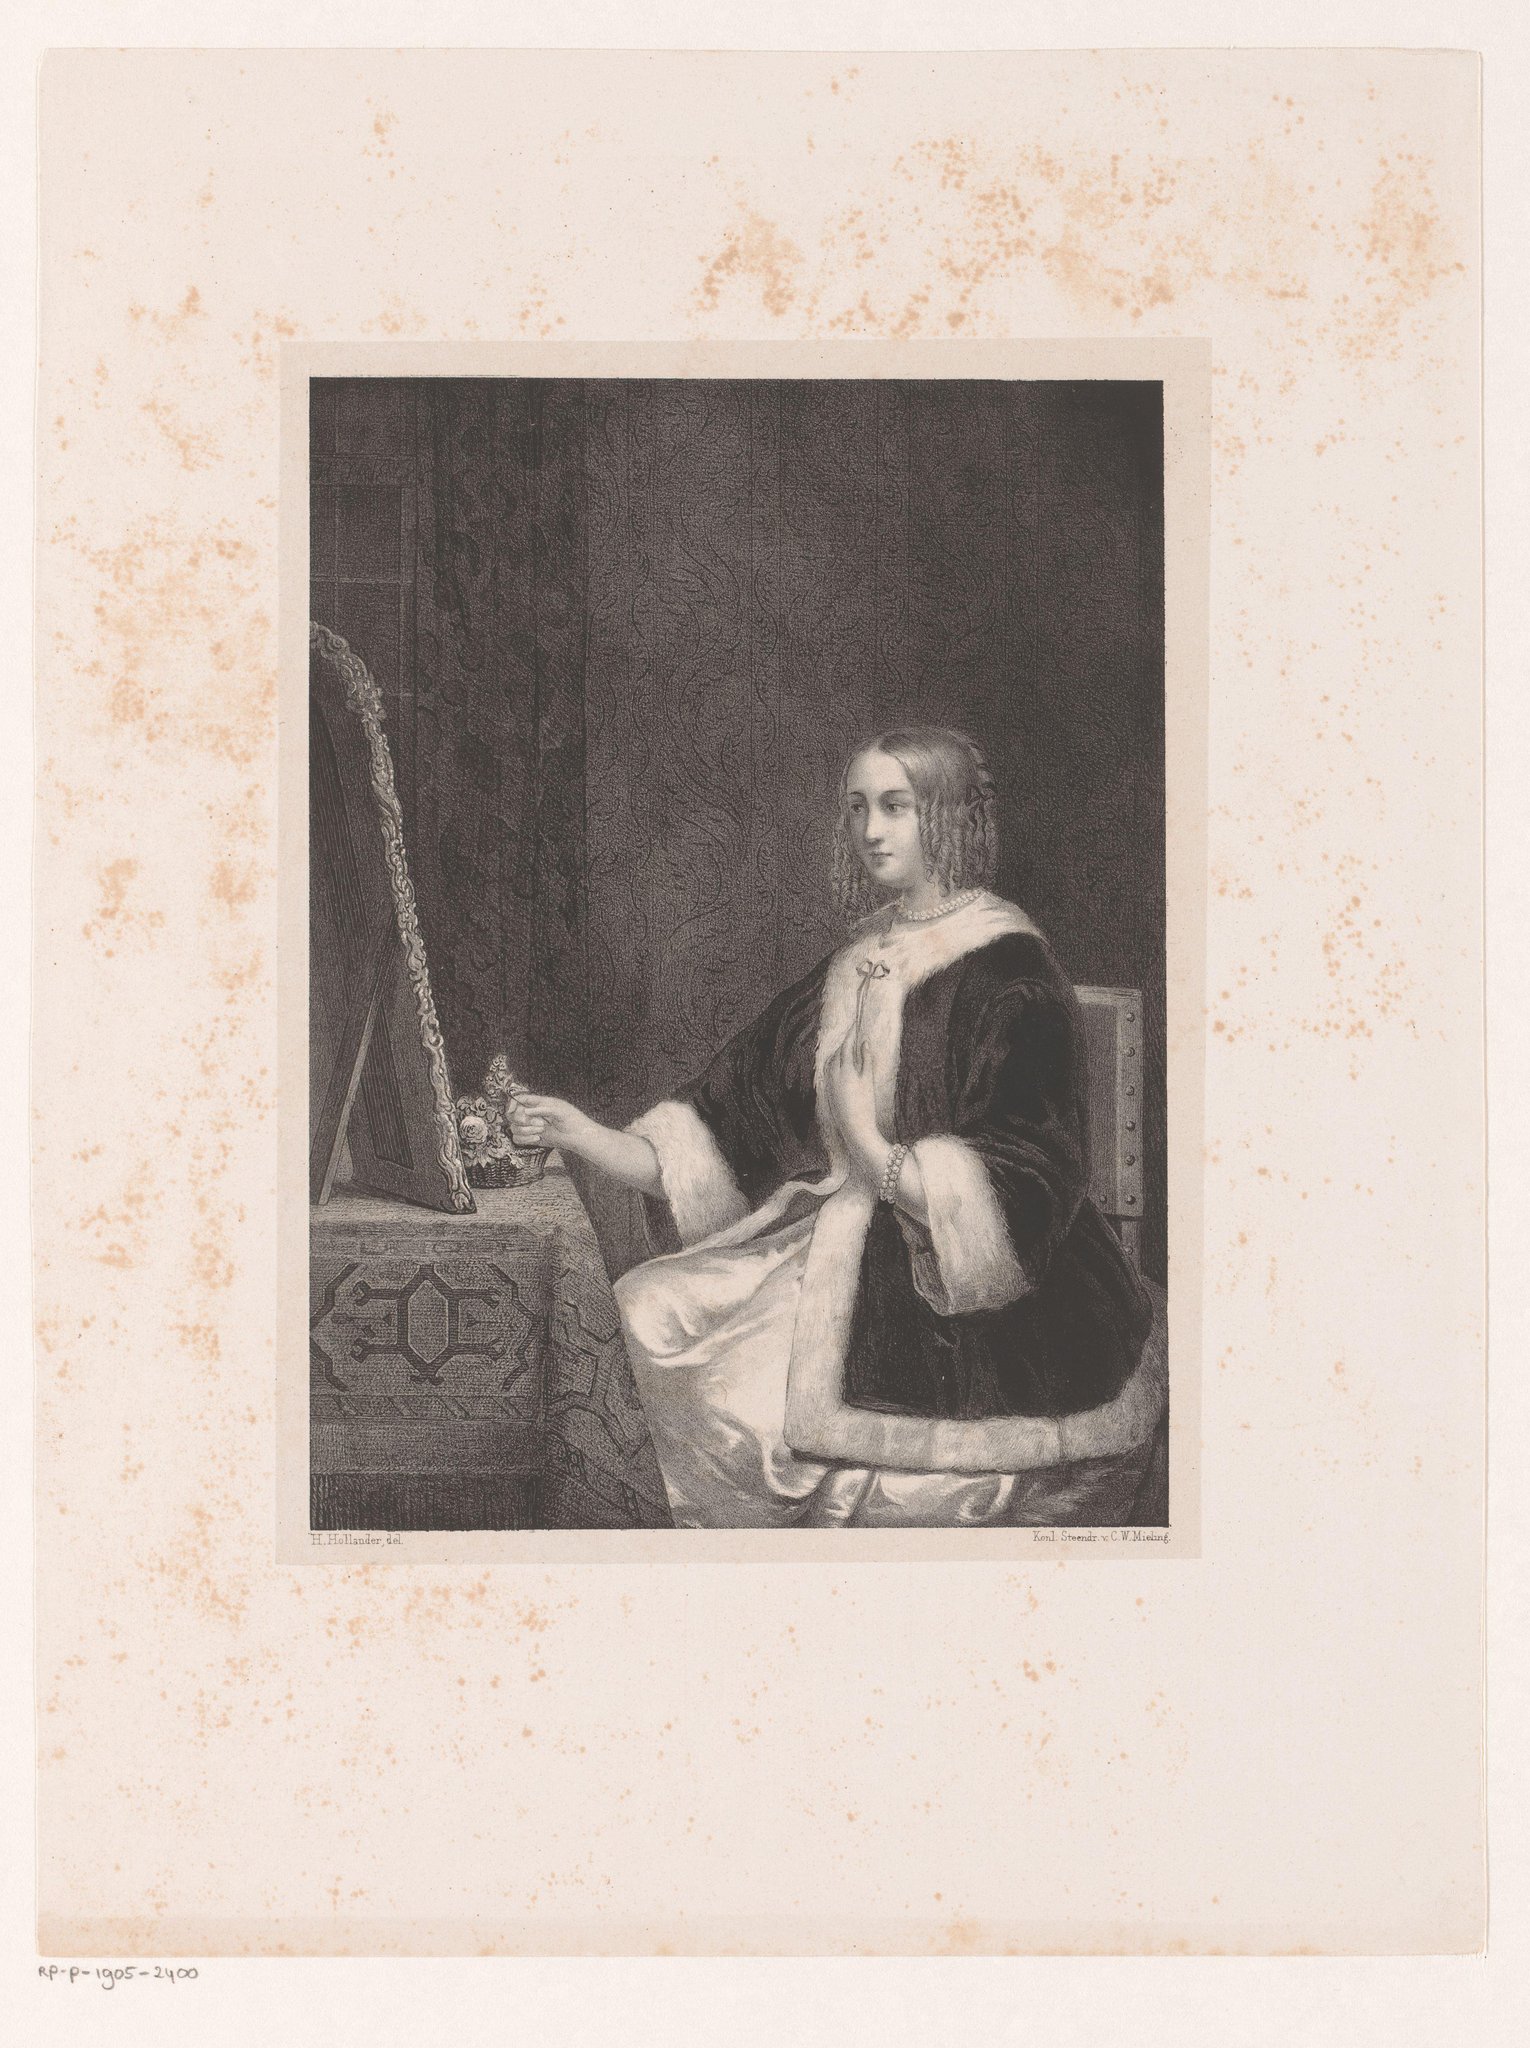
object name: print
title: Dame voor een spiegel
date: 1847-1865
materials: paper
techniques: lithograph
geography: the hague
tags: cut flowers; nosegay, bunch of flowers, mirror, making toilet - aa - (for) women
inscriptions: collector's mark: Lugt 2228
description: Met haar rechterhand neemt zij bloemen uit een mandje voor zich op tafel.